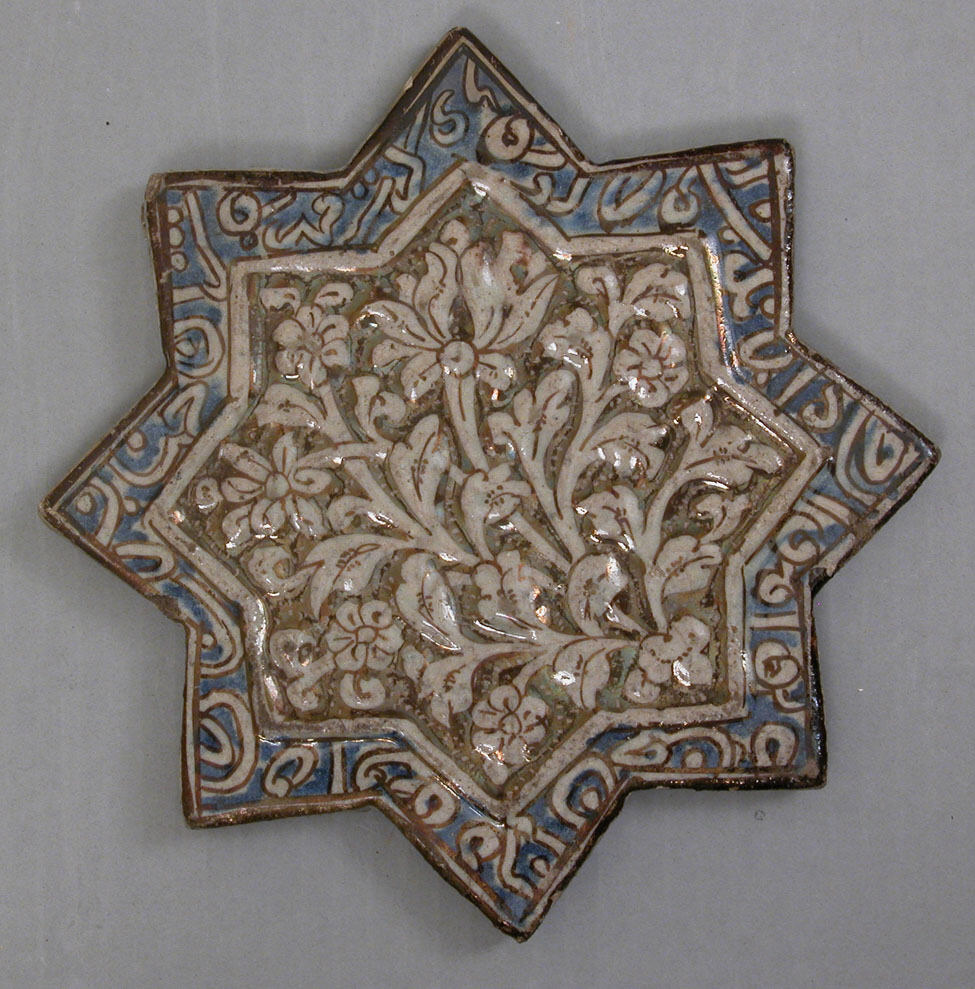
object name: tile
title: Star-Shaped Tile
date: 1301-1400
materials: glaze, stonepaste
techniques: luster painting, painting, underglaze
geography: iran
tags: flowers